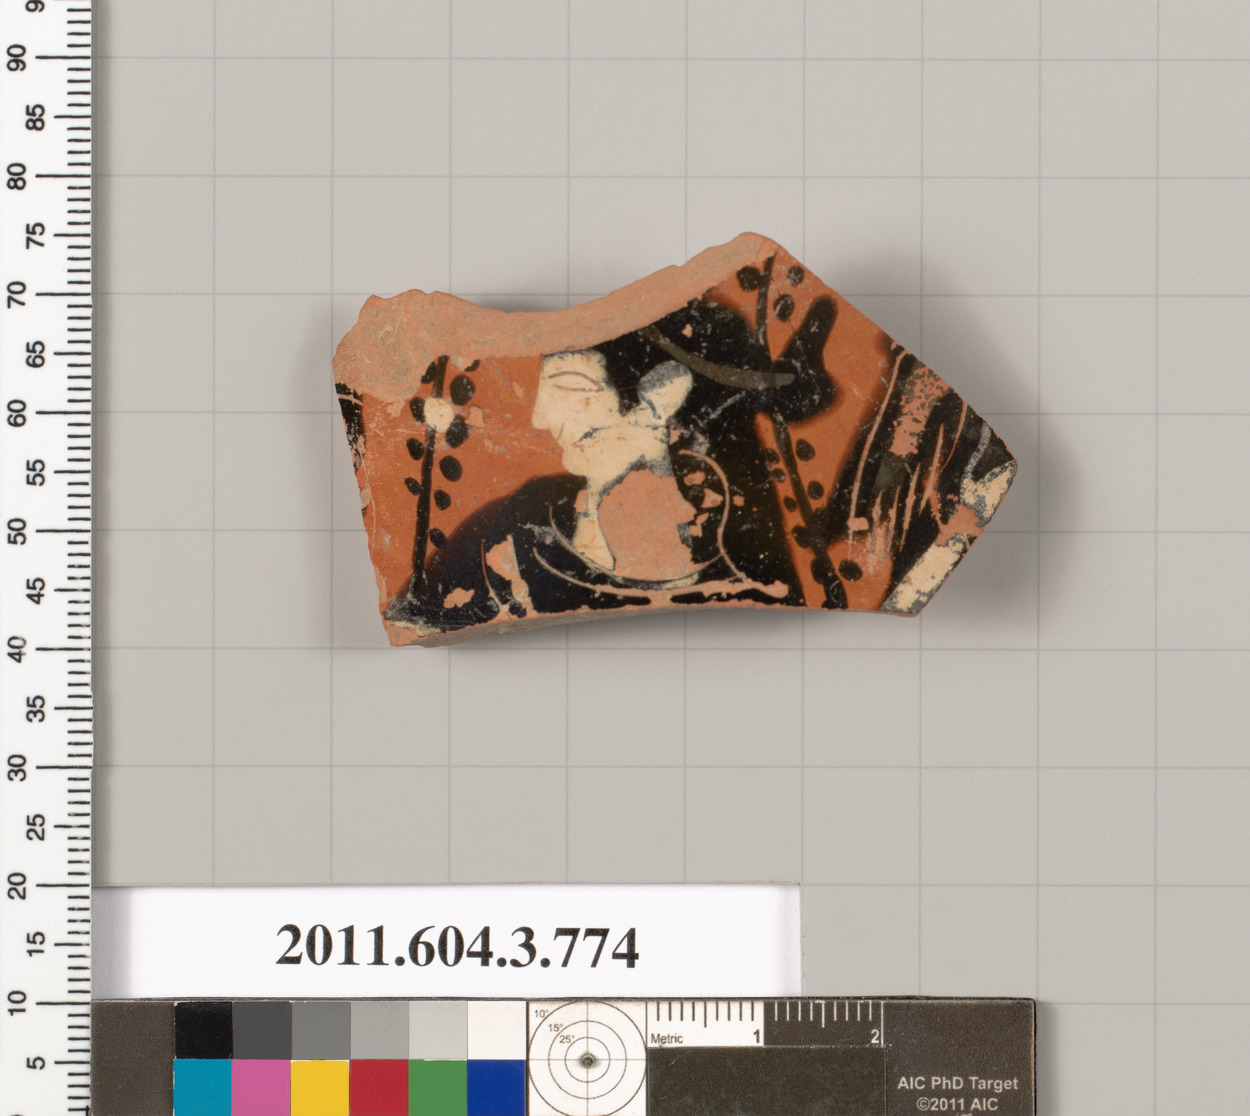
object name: oinochoe fragment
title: Terracotta fragment of an oinochoe (jug)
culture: greek, attic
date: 534-468 BCE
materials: terracotta